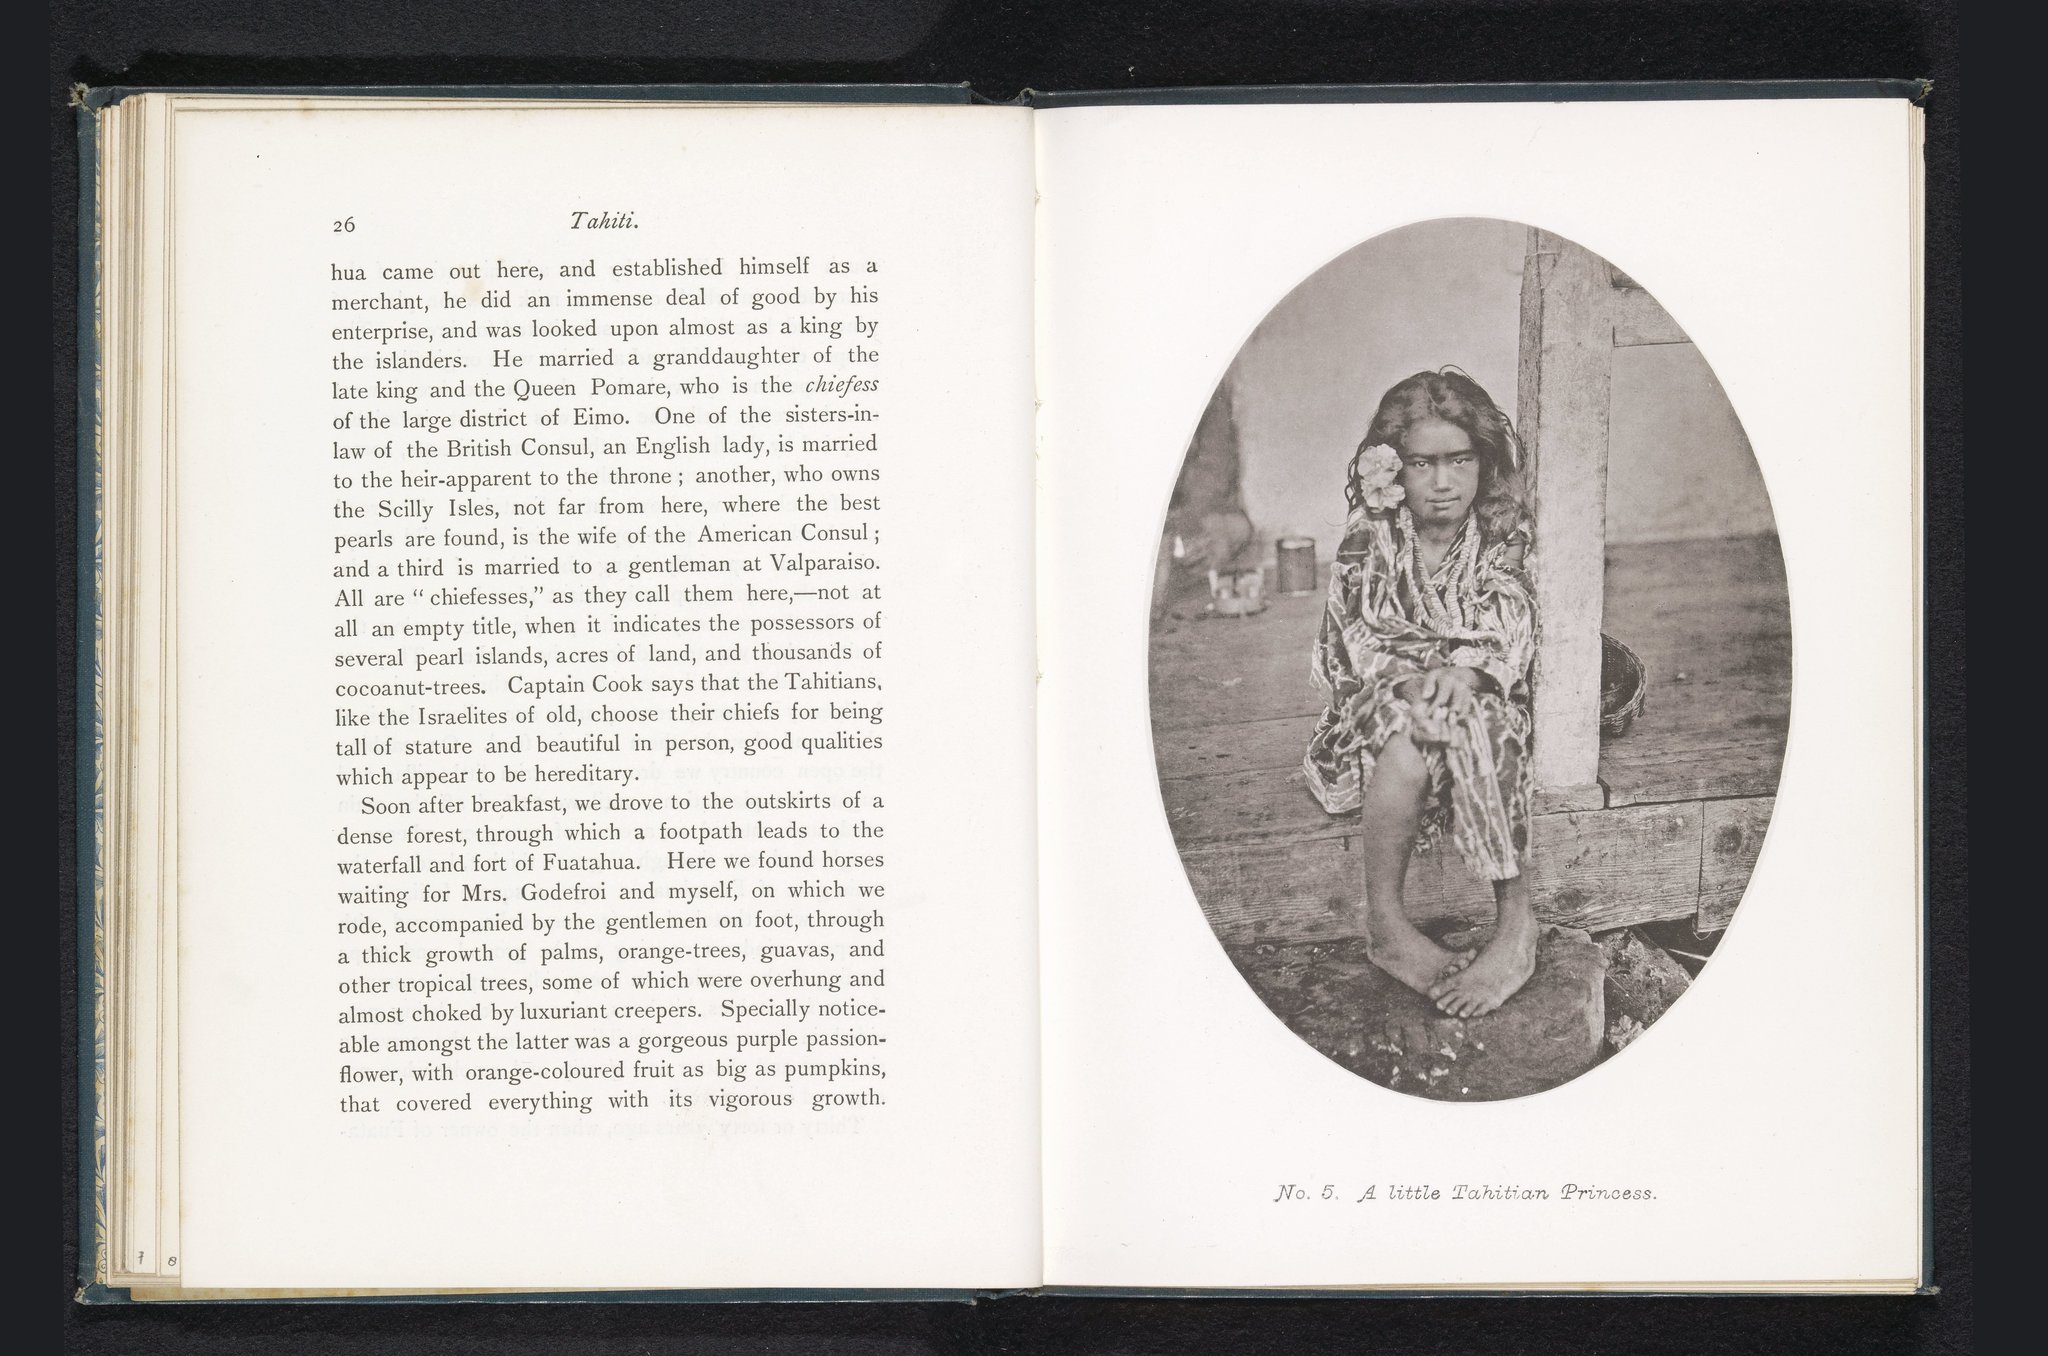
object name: photomechanical print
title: Portret van een onbekend meisje uit Tahiti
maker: henry stuart-wortley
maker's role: fotograaf, kolonel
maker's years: 1832-1890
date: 1880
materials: paper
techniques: photograph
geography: tahiti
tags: child (at home) - aa - girl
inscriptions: number: ‘No. 5.’